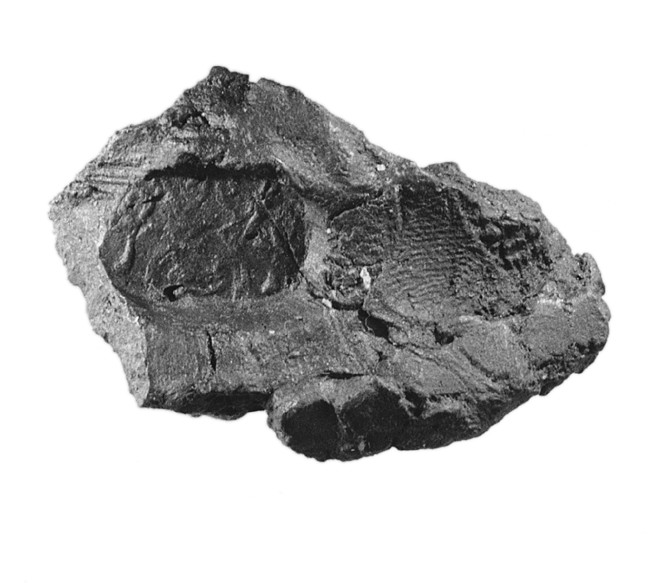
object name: sealing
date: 2030-1640 BCE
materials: clay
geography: egypt